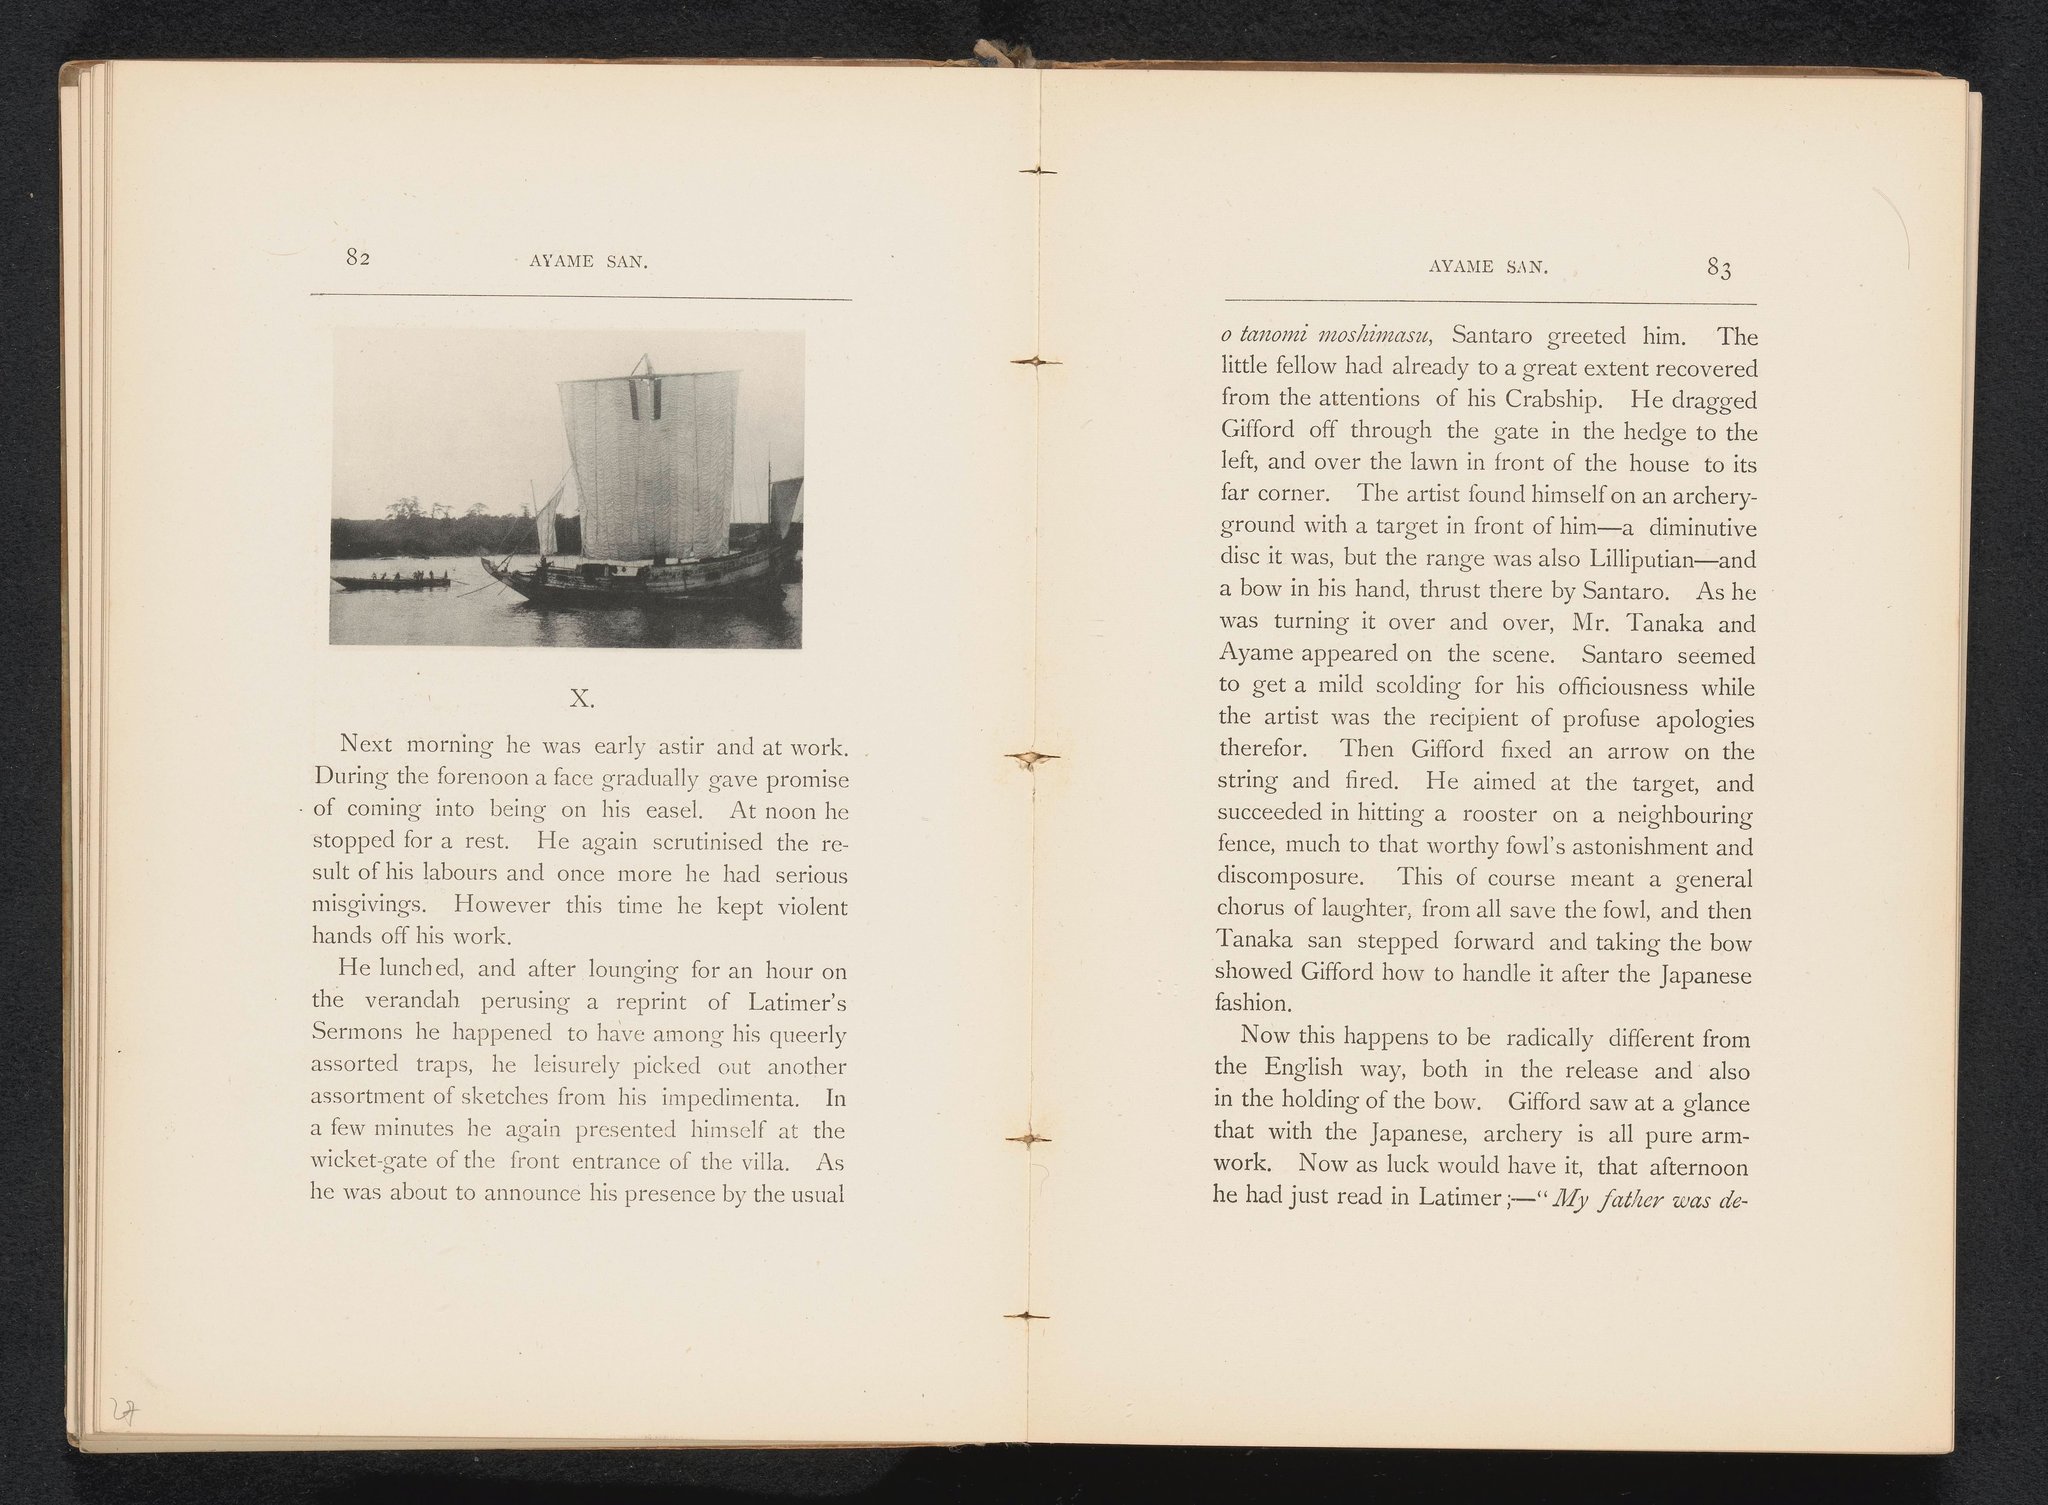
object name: page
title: Zeilschip en een roeiboot op een rivier te Japan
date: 1882-1892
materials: paper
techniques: photograph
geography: japan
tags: sailing-ship, sailing-boat, river, rowing-boat, canoe, etc.